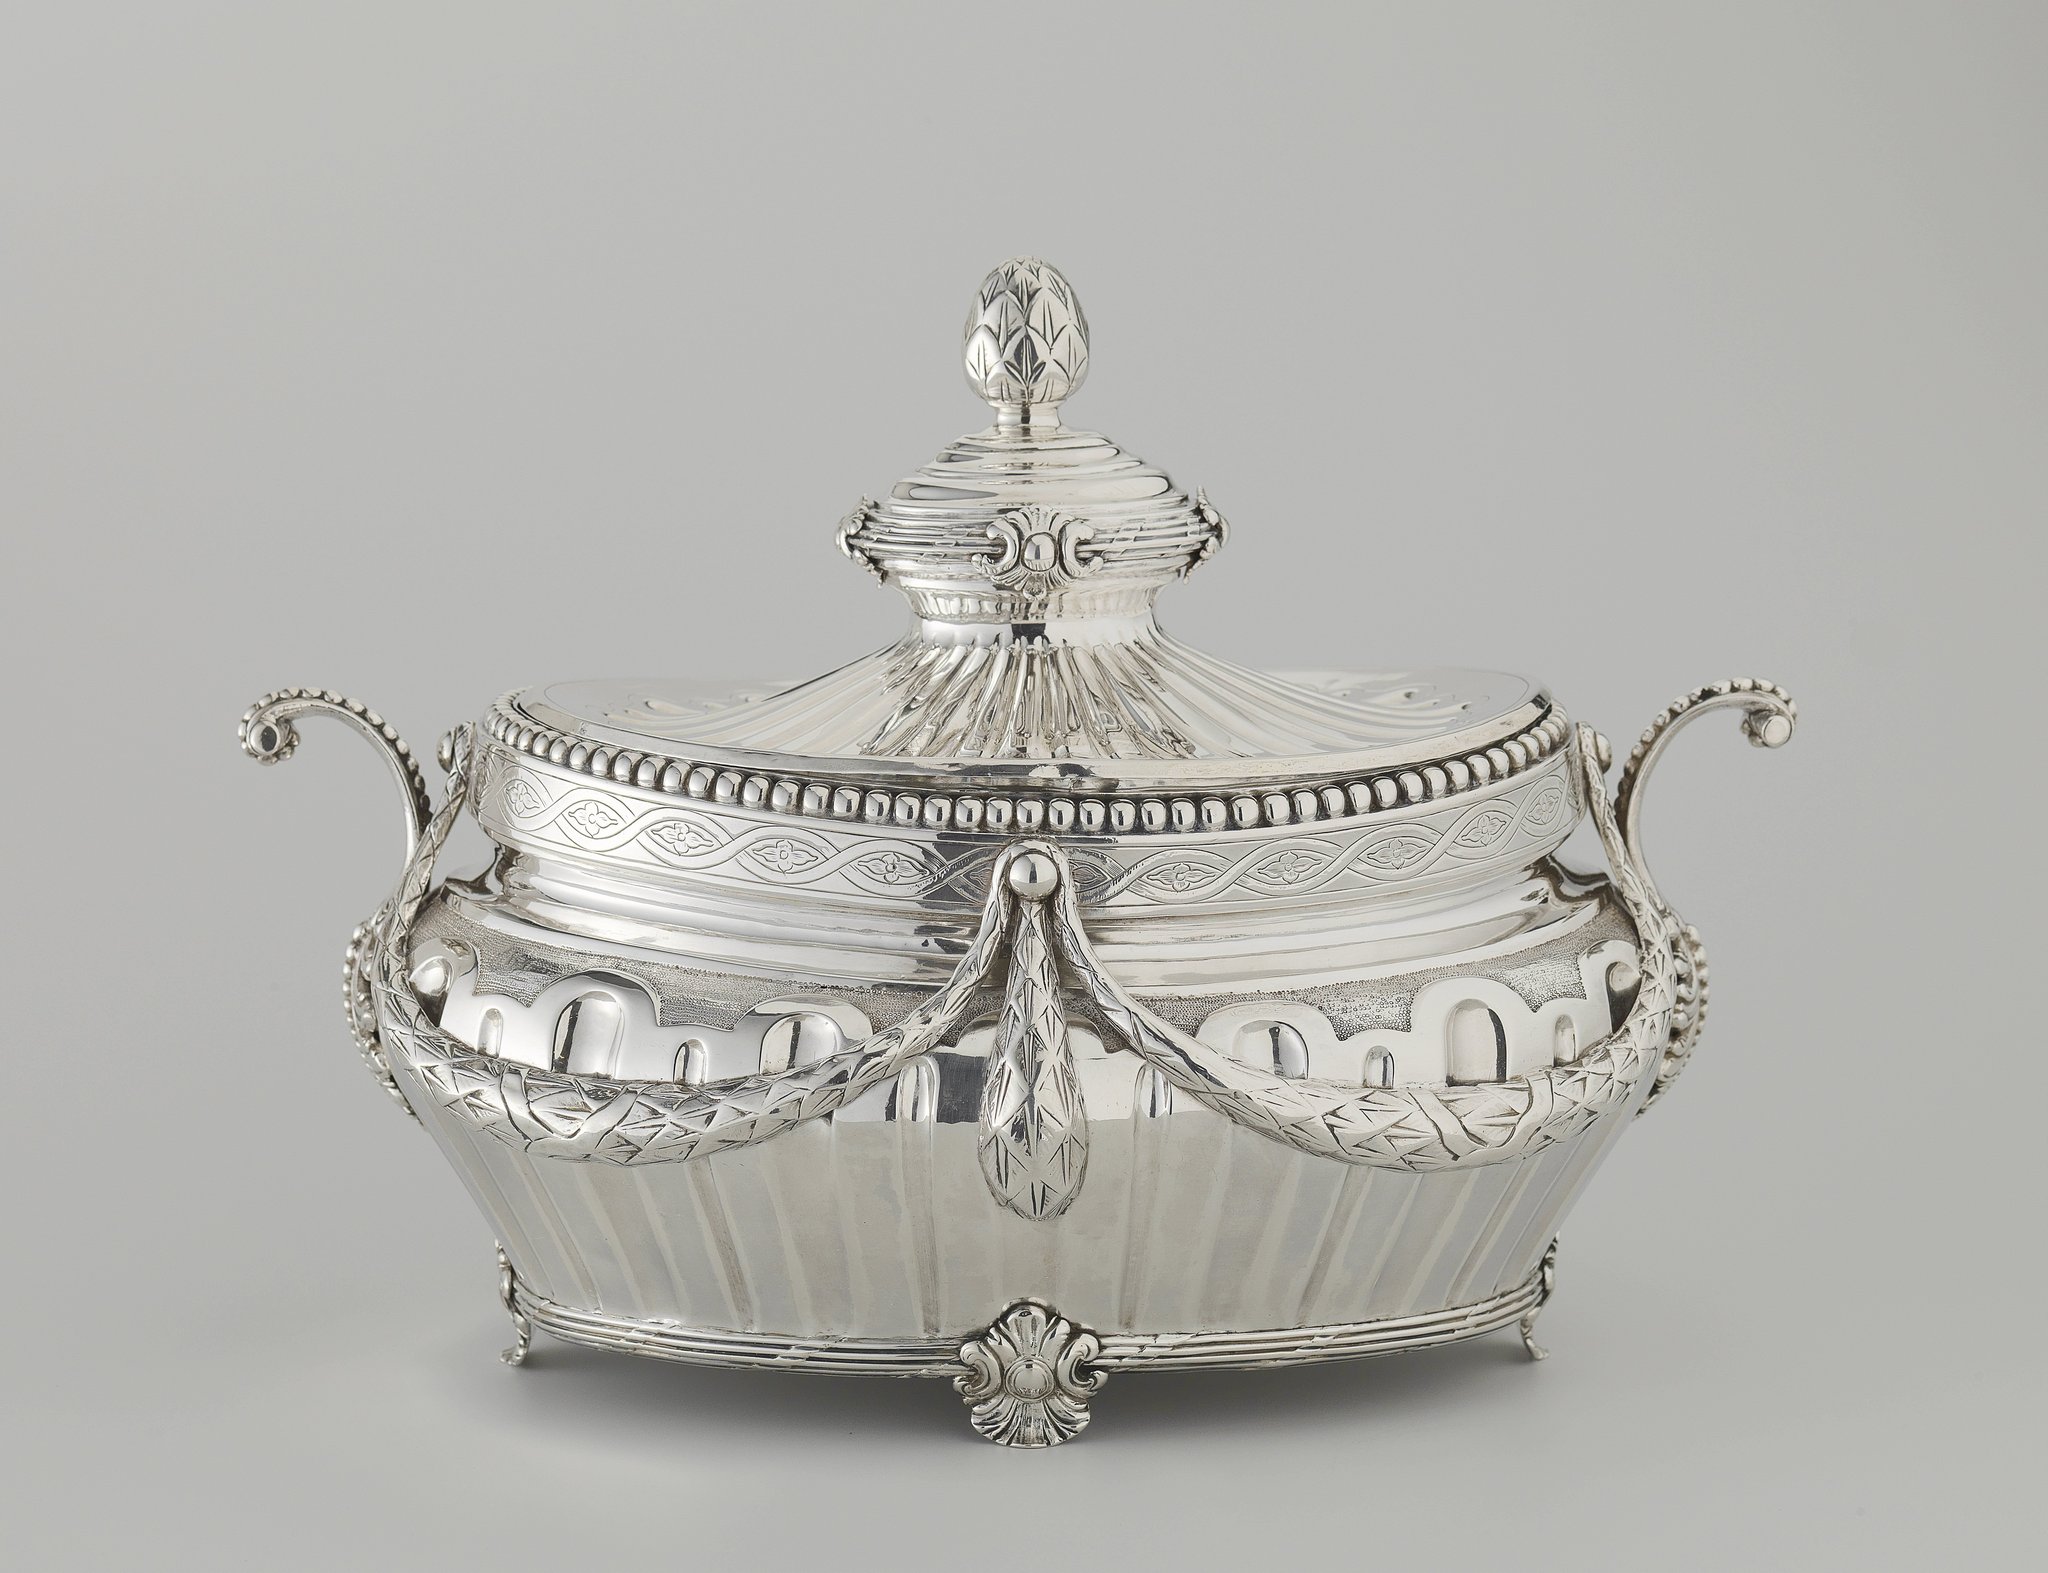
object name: tureen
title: Een grote (A) en twee kleine (B en C) ovale terrines in Lodewijk XVI-stijl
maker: philippus priee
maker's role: silversmith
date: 1773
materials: silver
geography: middelburg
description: Three tureens. Silver. Middelburg, 1773, by Philippus Prié.